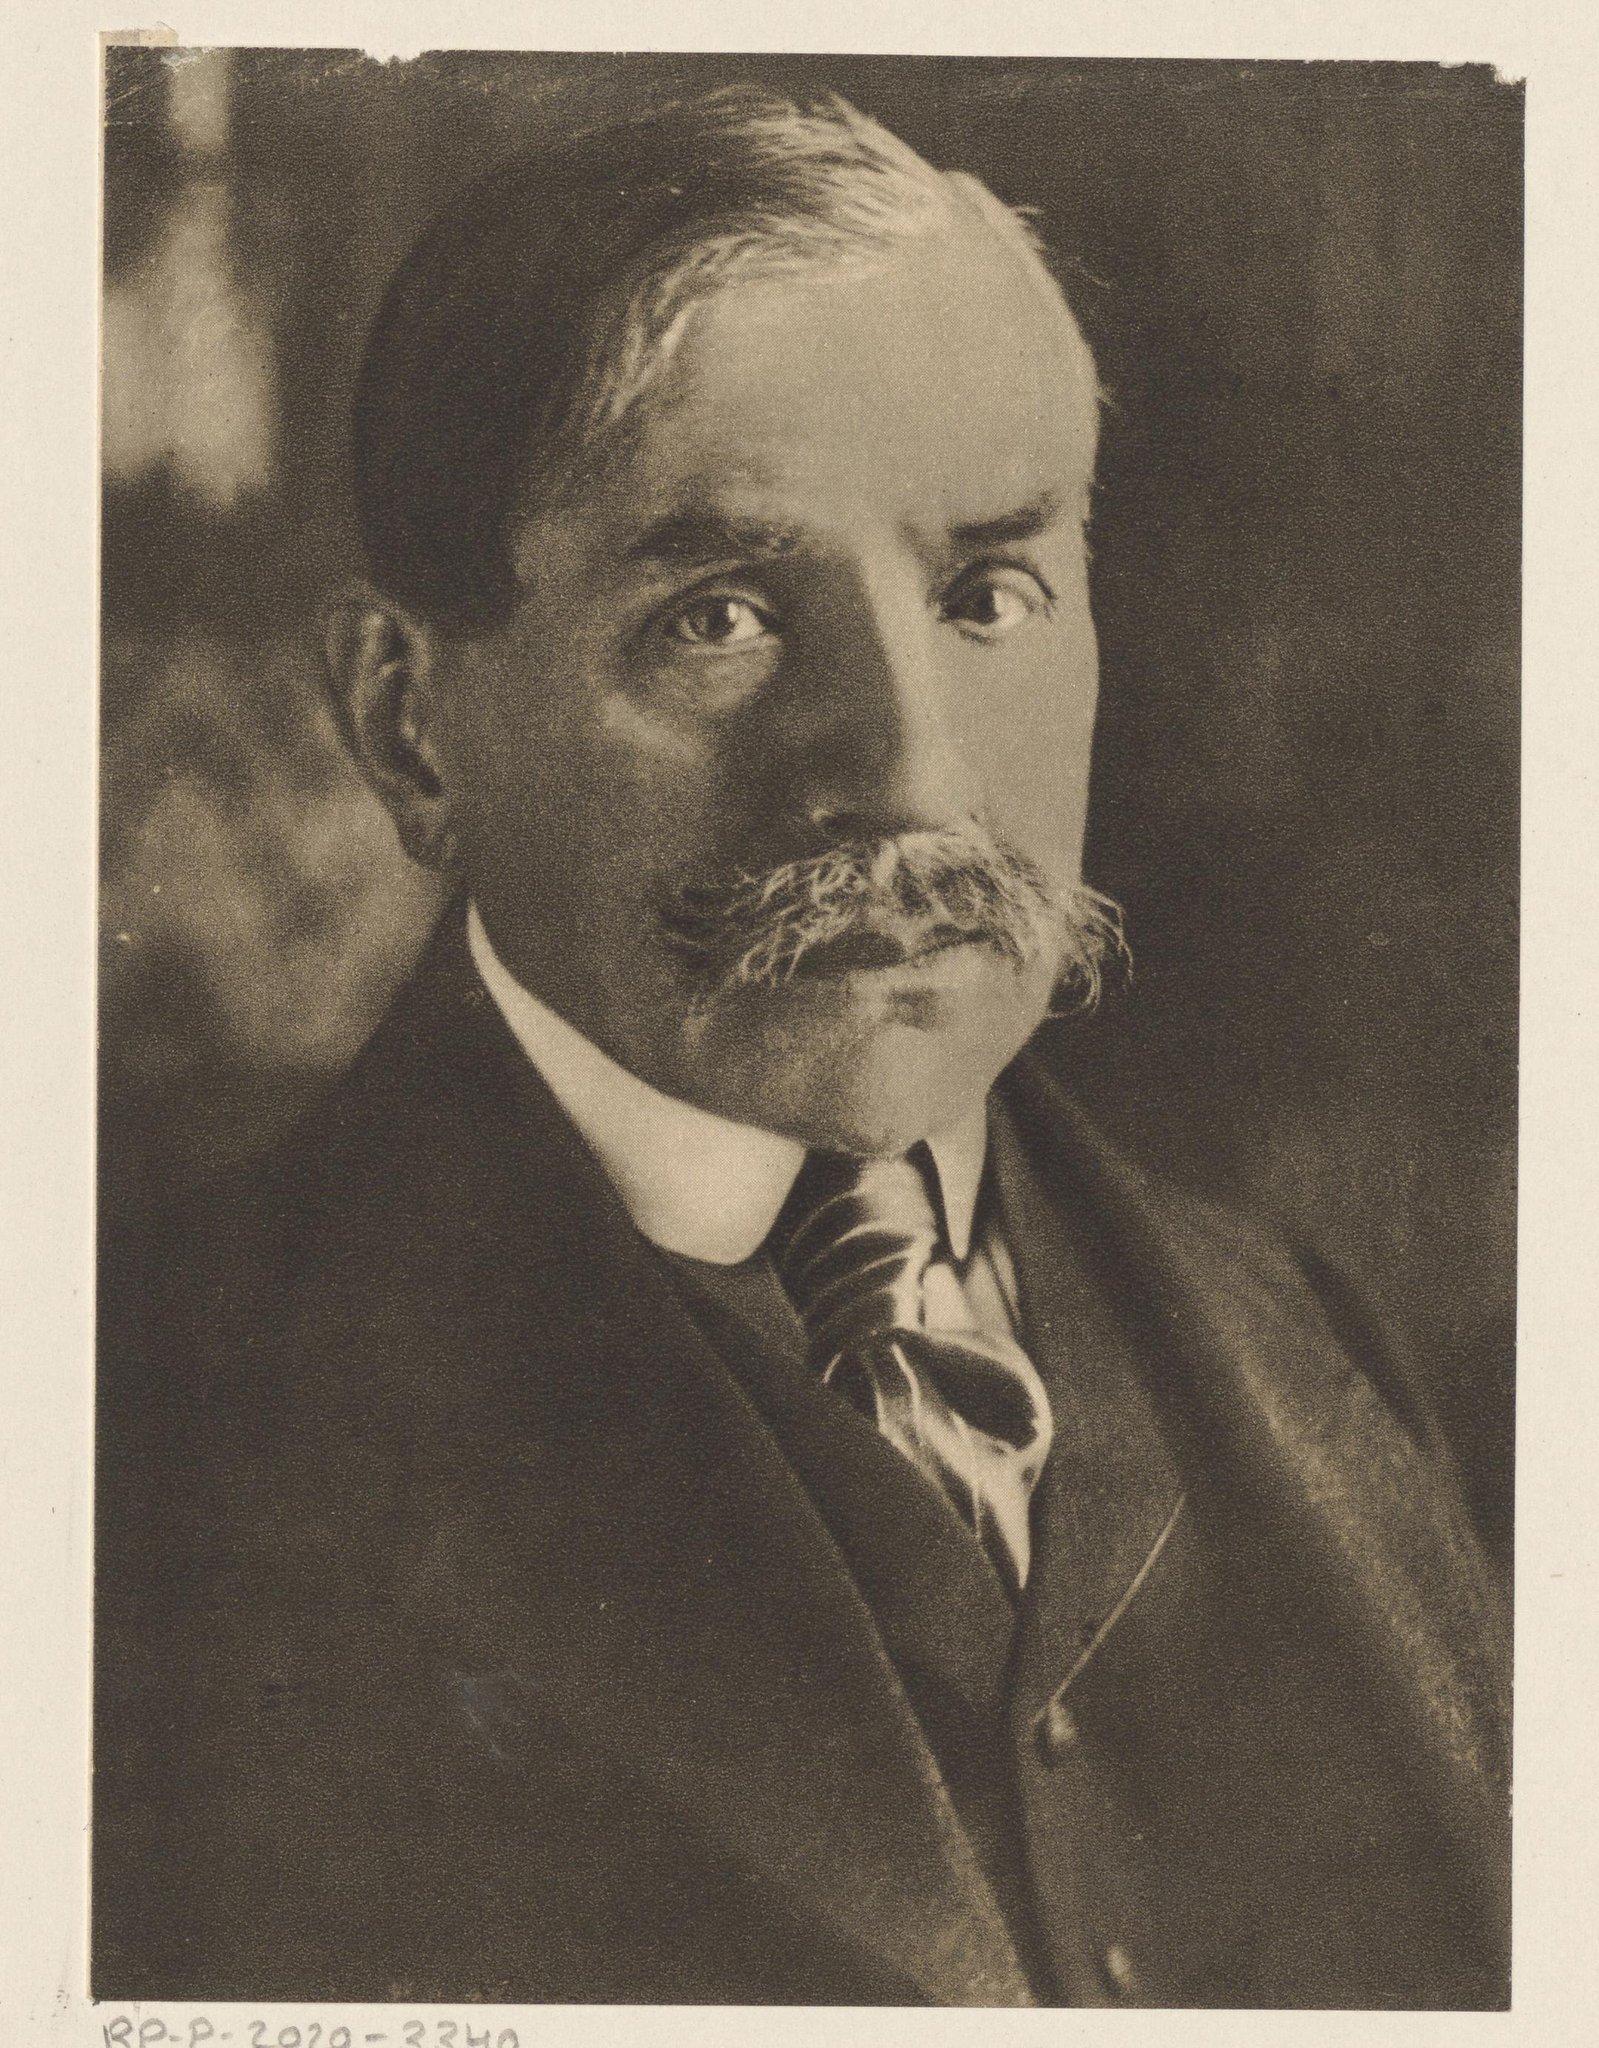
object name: photomechanical print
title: Portret van Paul Bourget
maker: Anonymous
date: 1900-1925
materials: paper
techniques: rotogravure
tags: historical persons, portrait of a writer